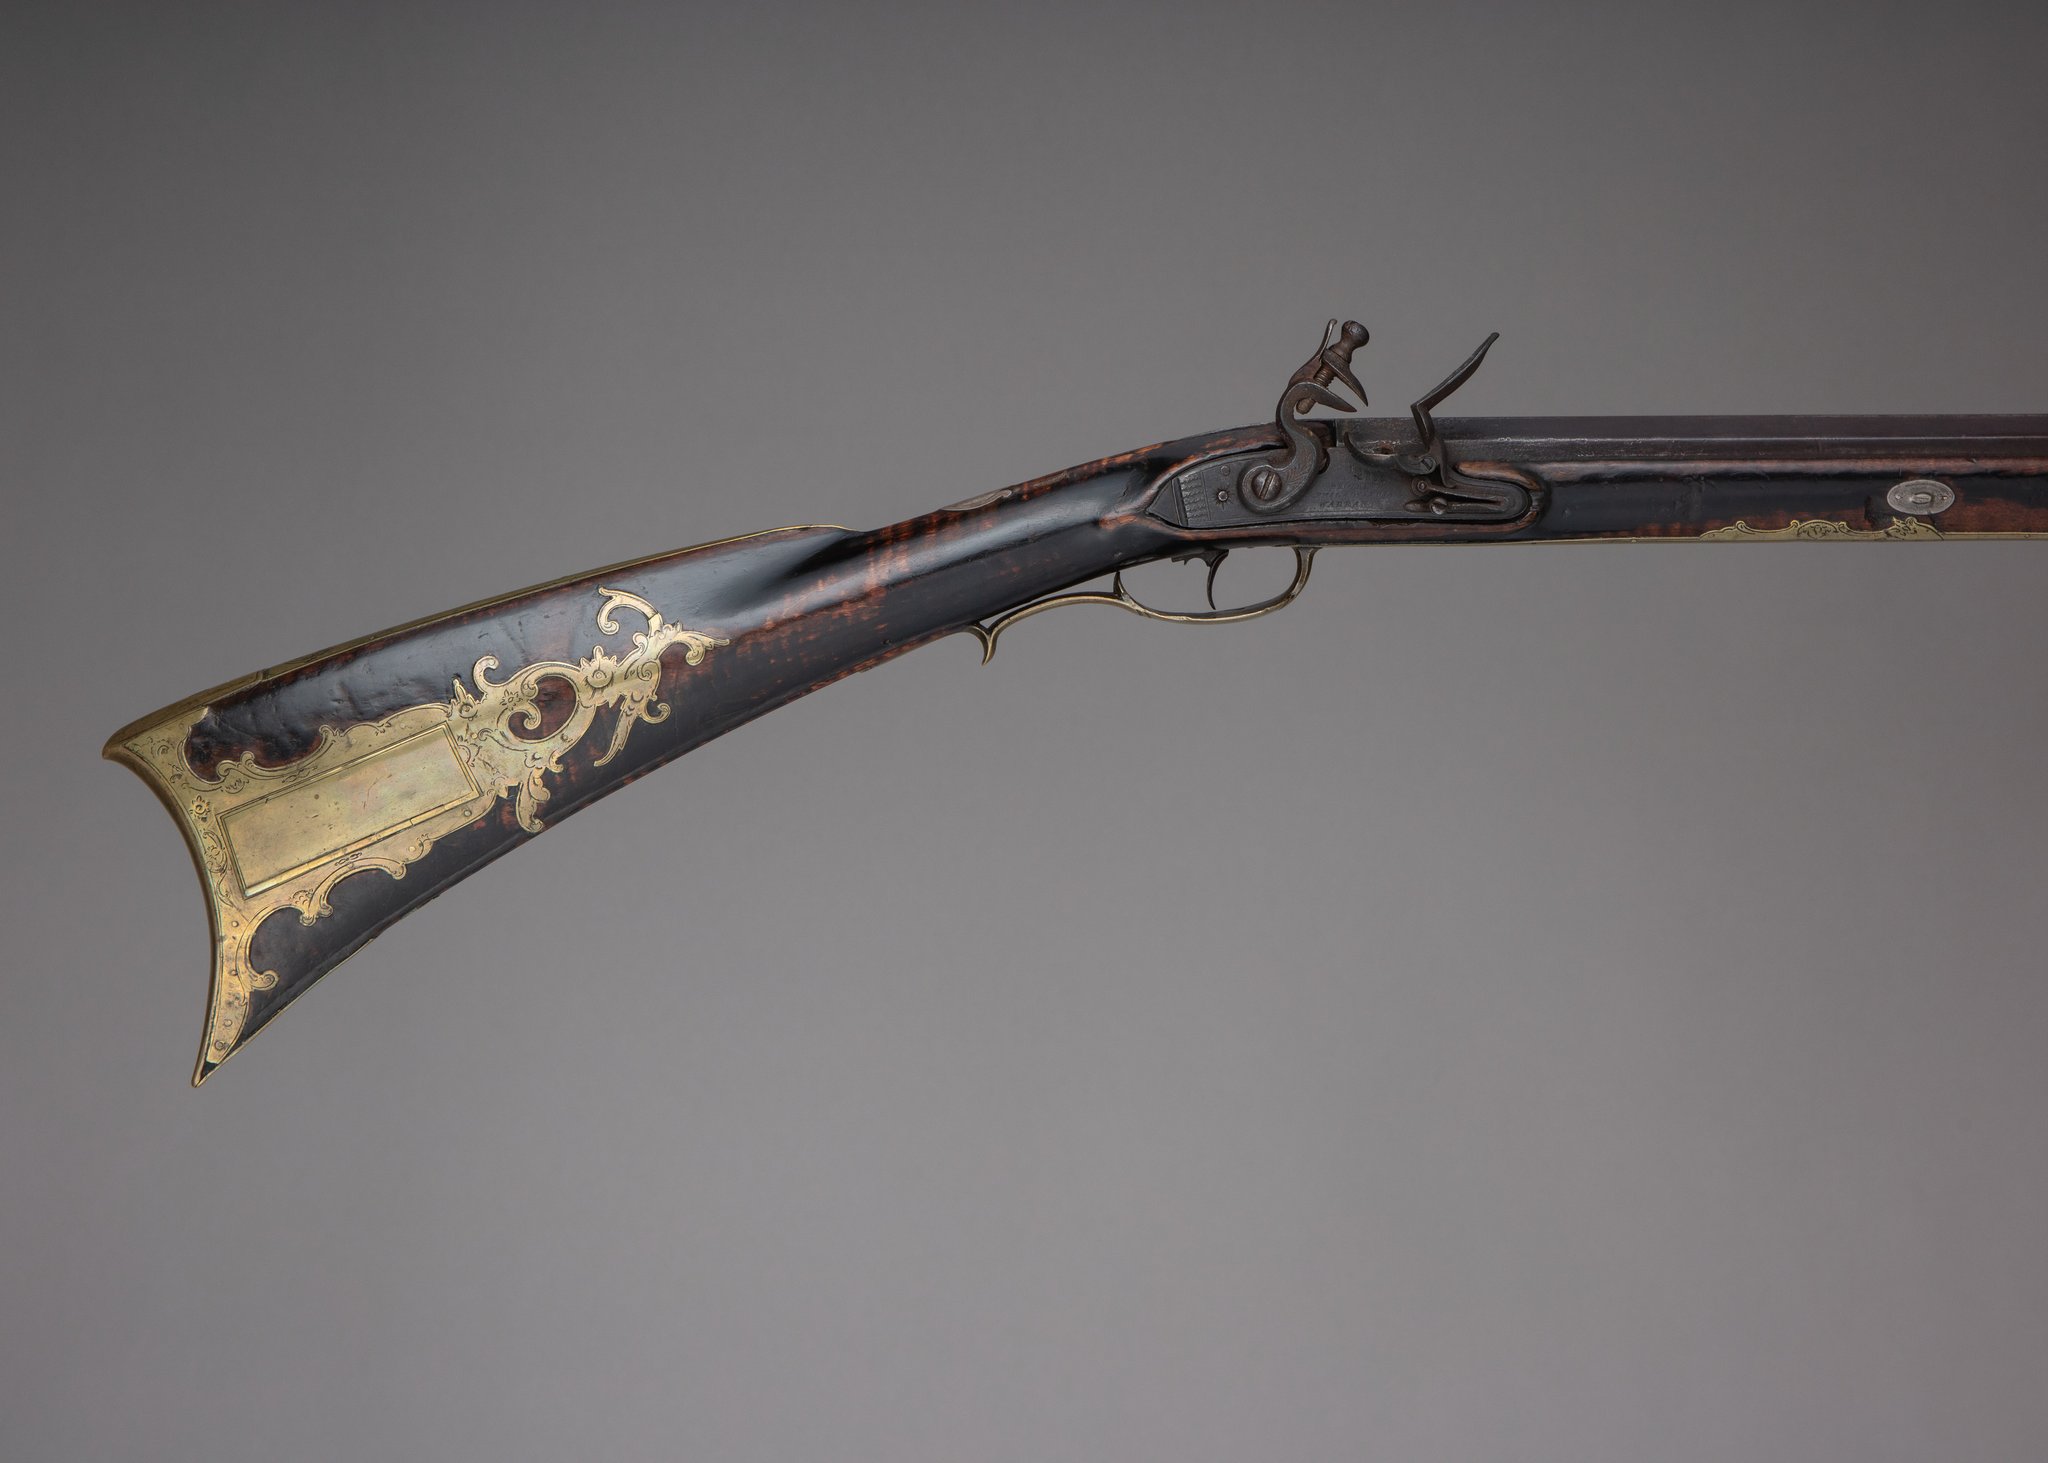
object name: flintlock longrifle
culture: american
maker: henry young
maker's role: gunsmith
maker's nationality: american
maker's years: 1750-1850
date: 1800-1820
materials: brass, iron, silver, steel, wood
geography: united states